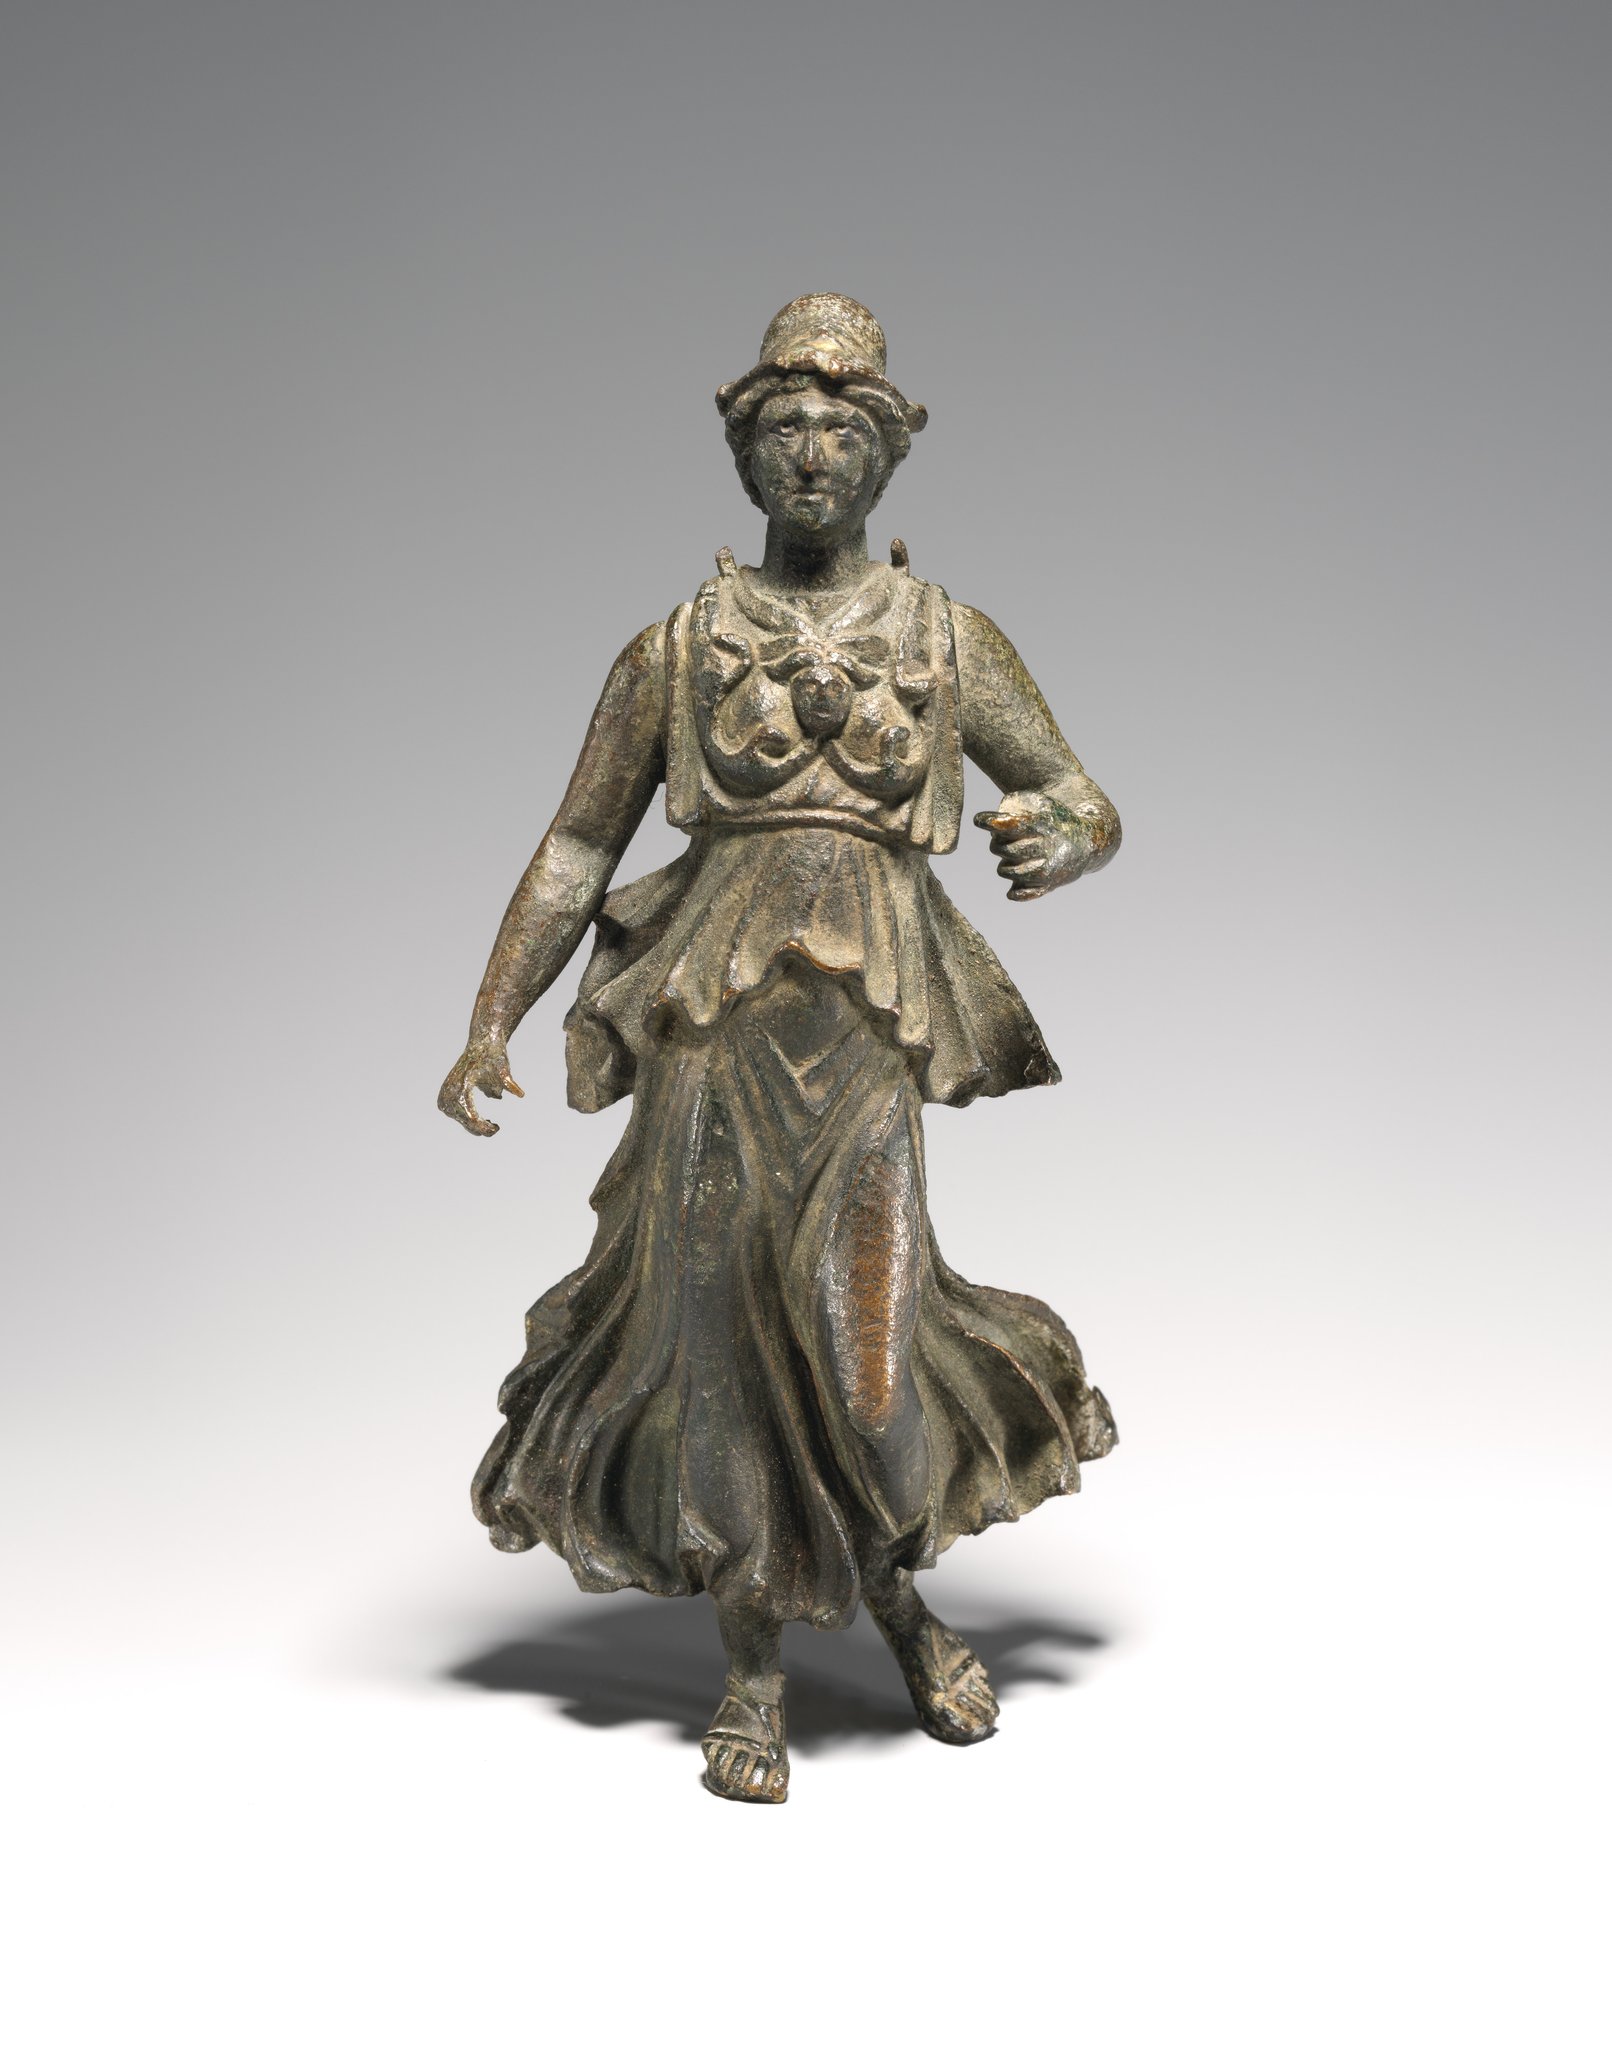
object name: statuette of athena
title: Bronze statuette of Minerva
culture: roman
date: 101-200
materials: bronze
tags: minerva